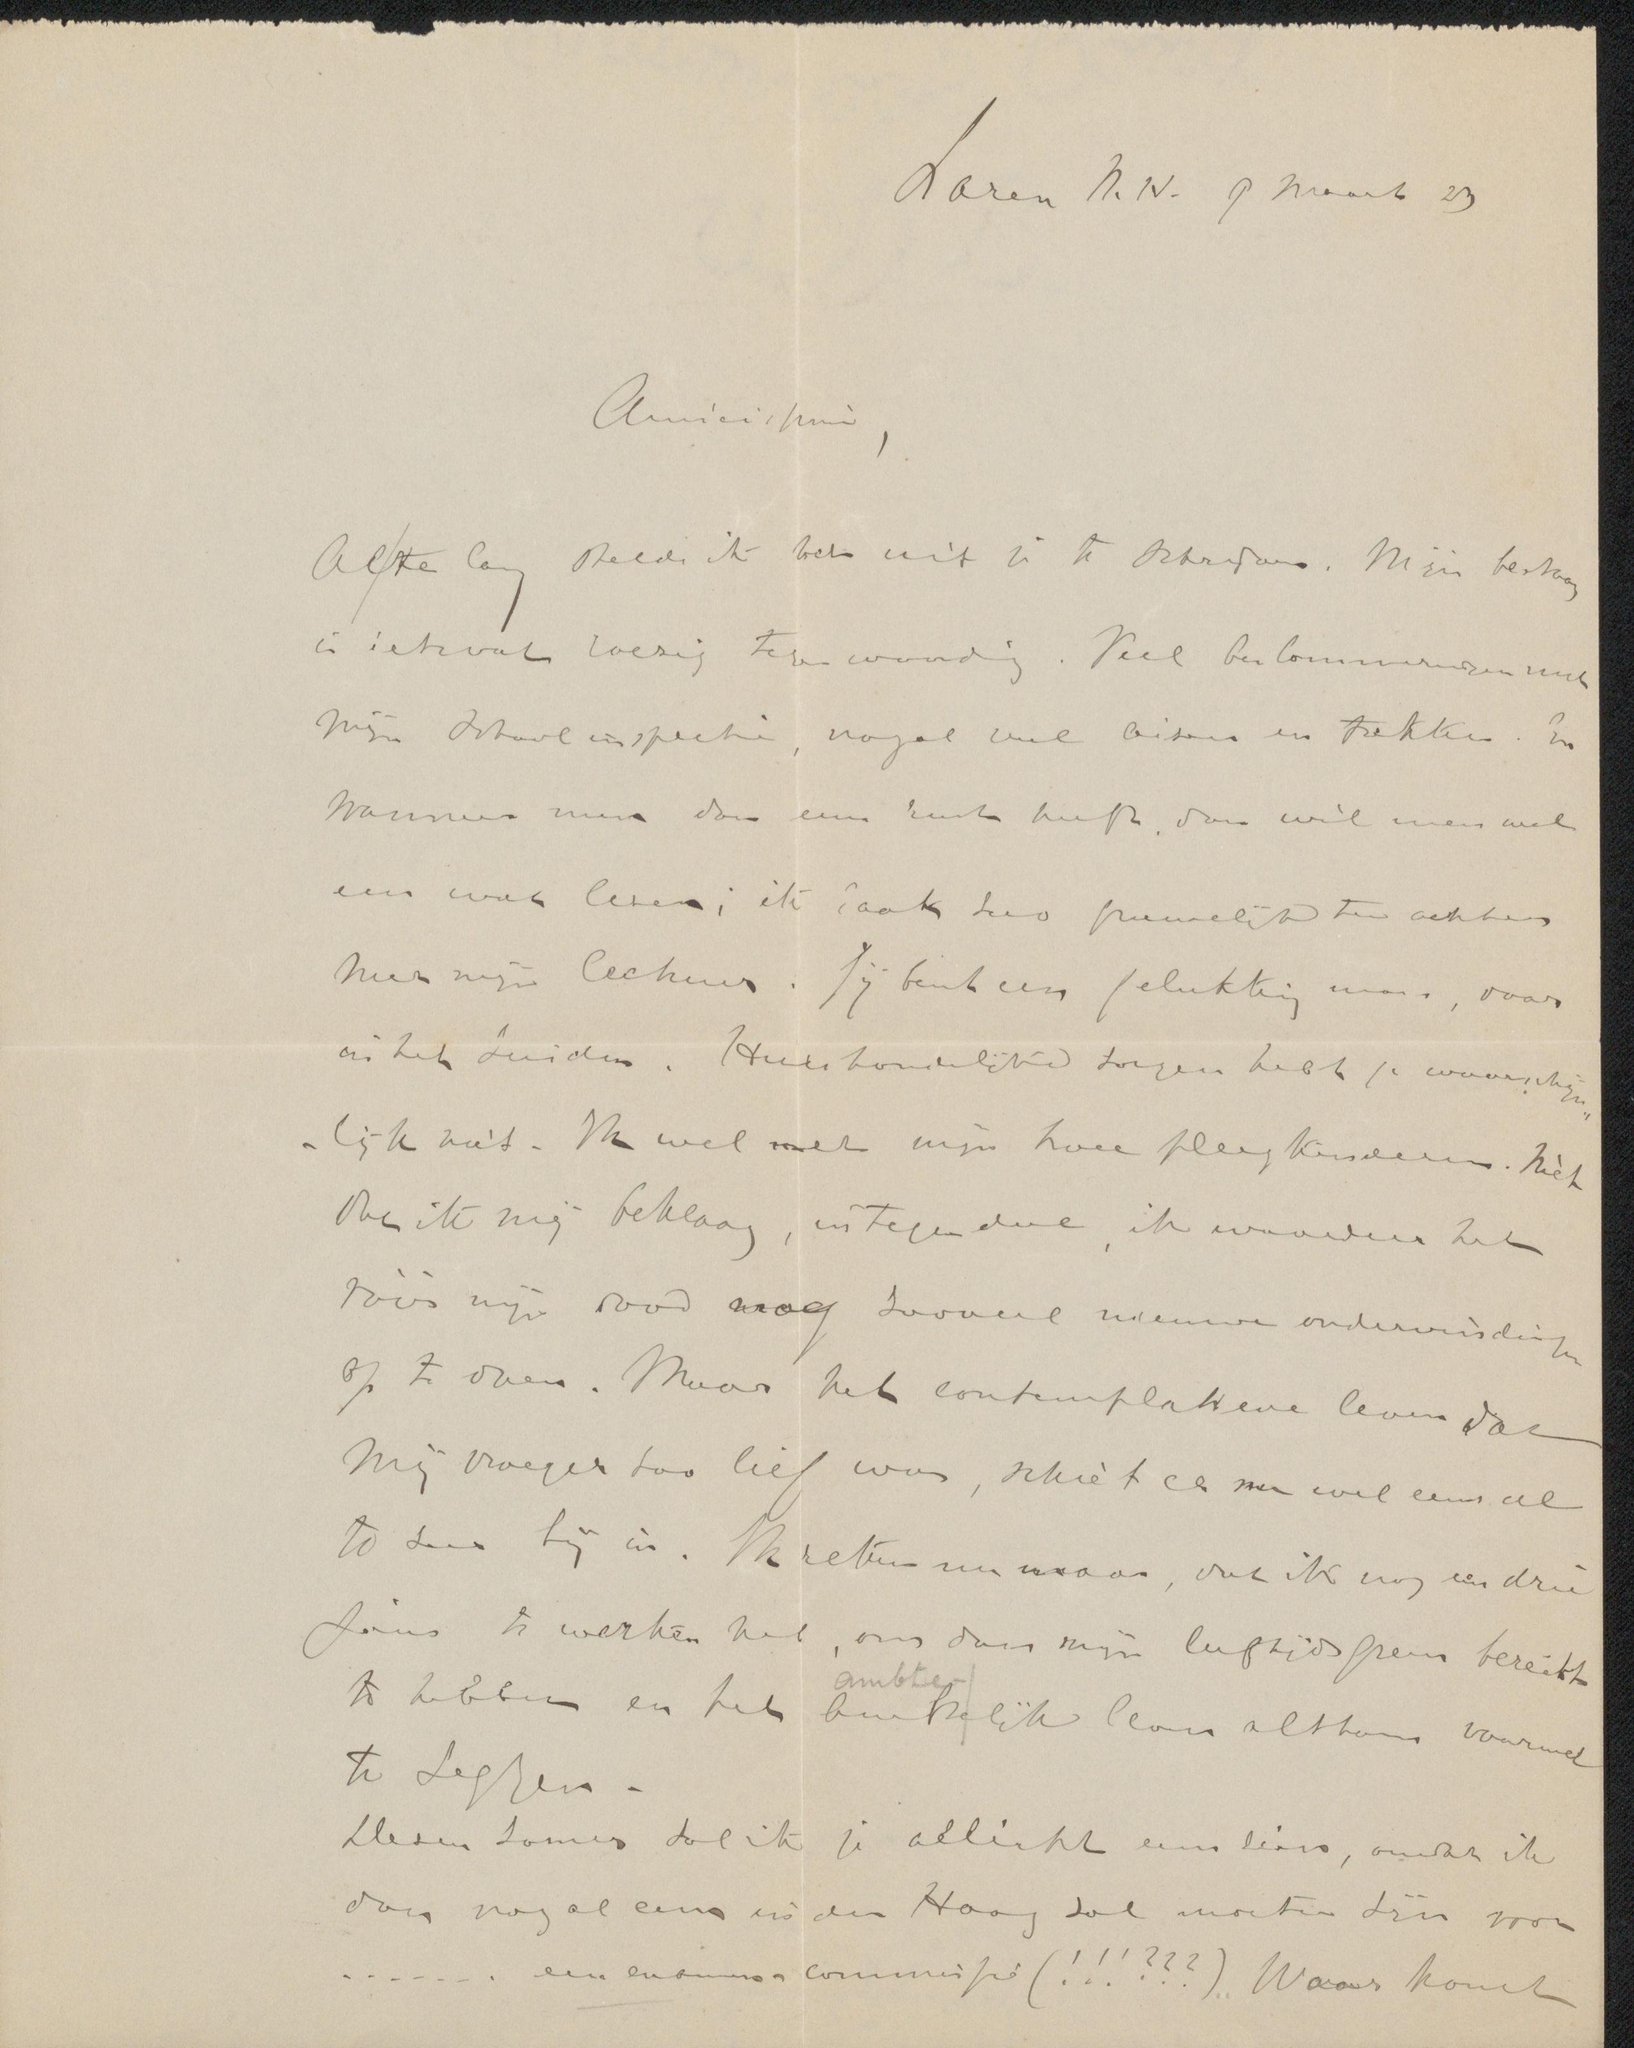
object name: letter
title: Brief aan Philip Zilcken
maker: adriaan pit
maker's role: print maker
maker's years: 1860-1944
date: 1923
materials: ink, paper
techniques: pen, writing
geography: laren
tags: the hague, painter, draughtsman, philip zilcken, family life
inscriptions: collector's mark: ‘RPK’